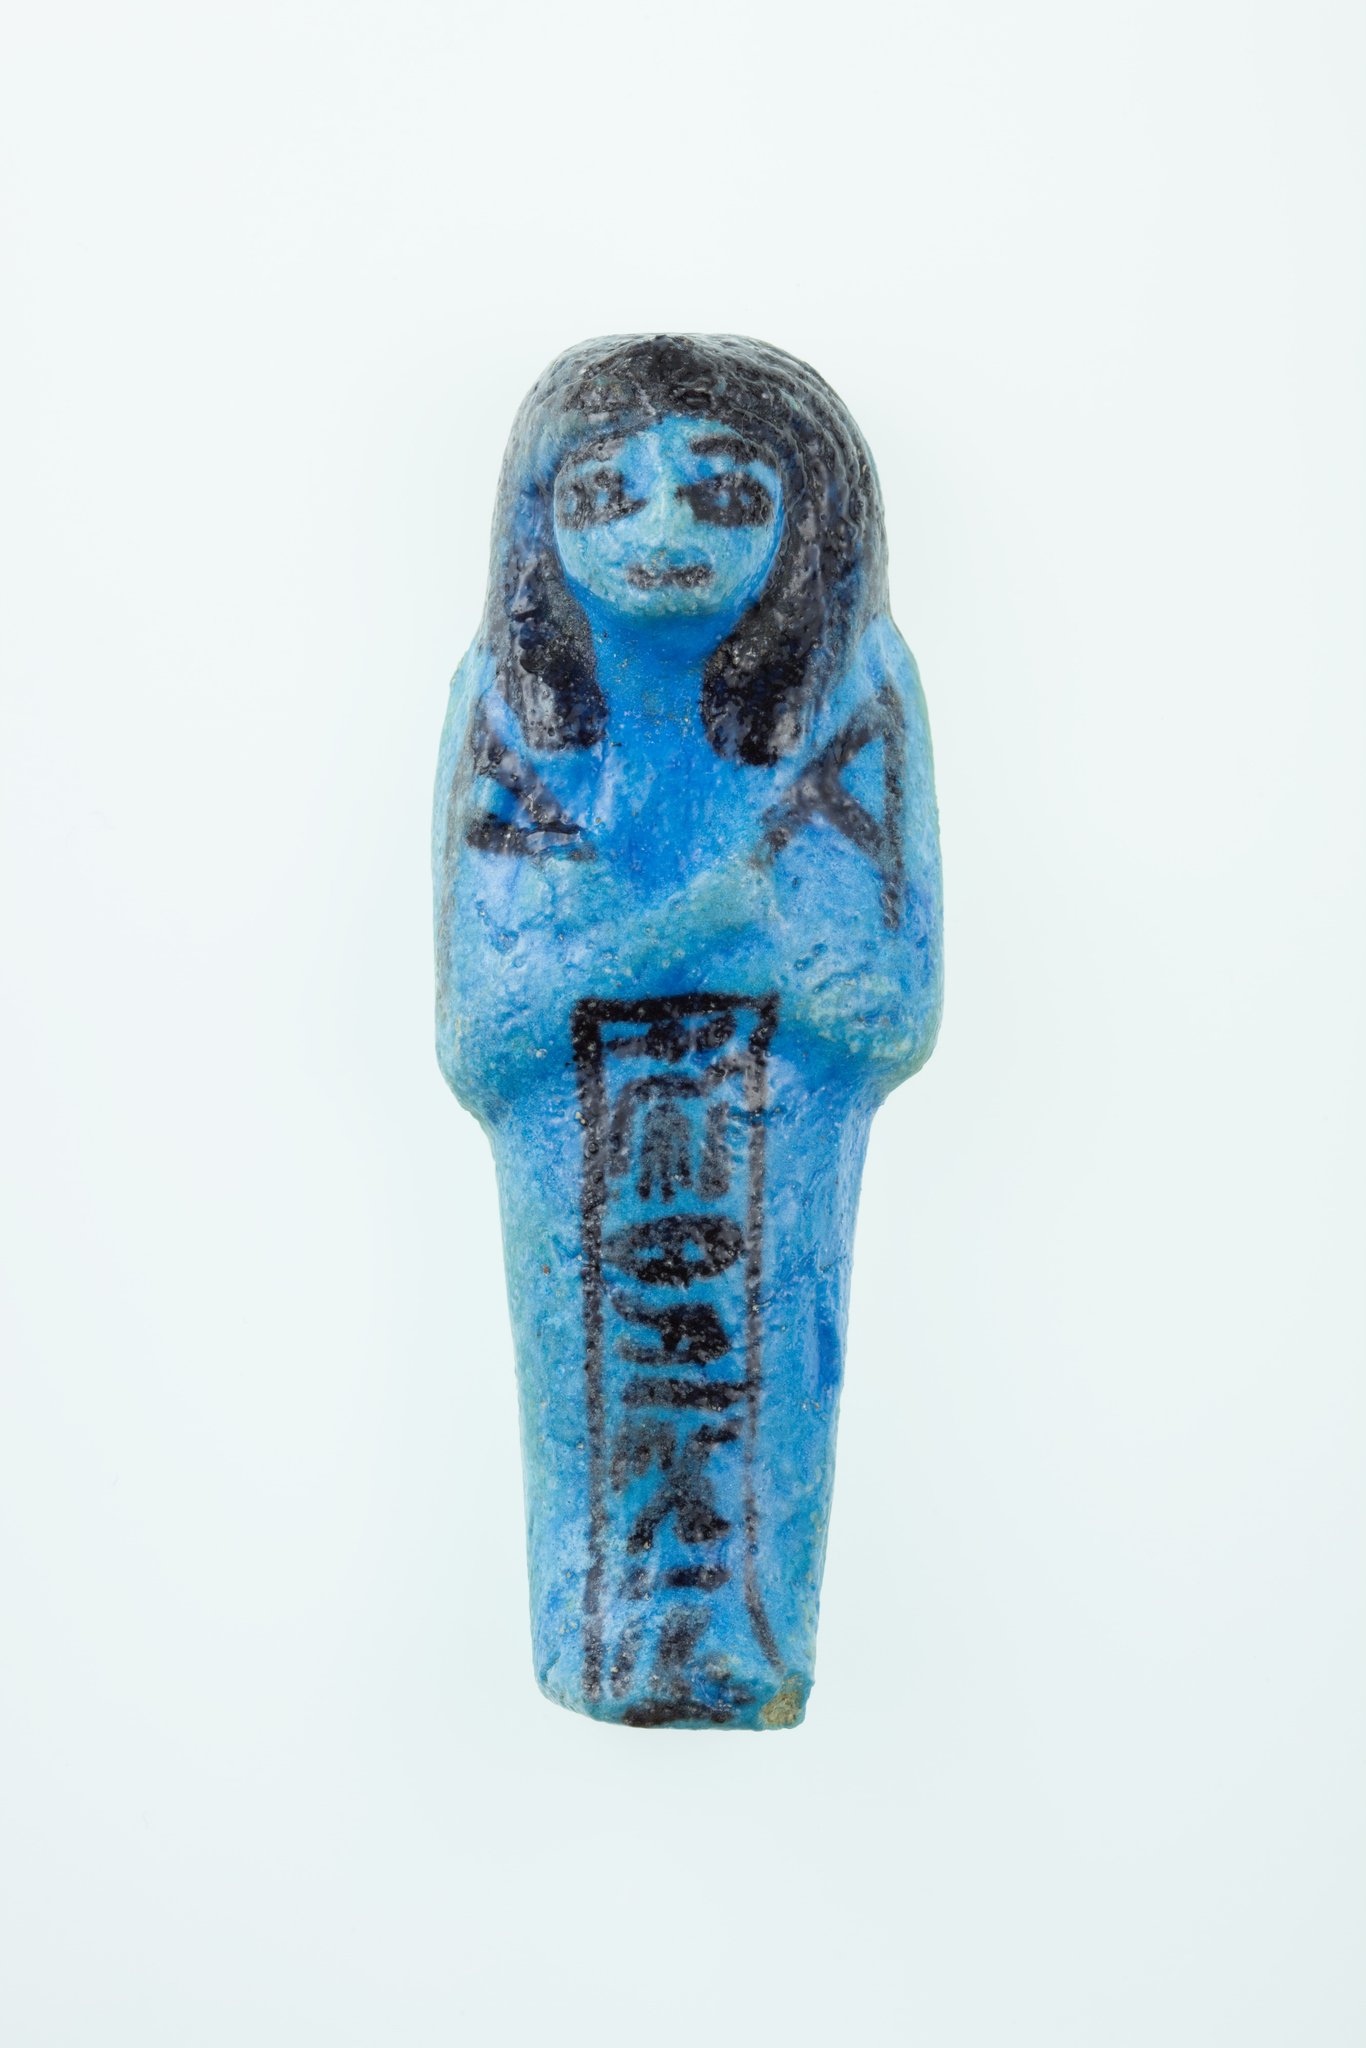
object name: shabti, worker, nauny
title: Worker Shabti of Nauny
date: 1050 BCE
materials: faience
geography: egypt